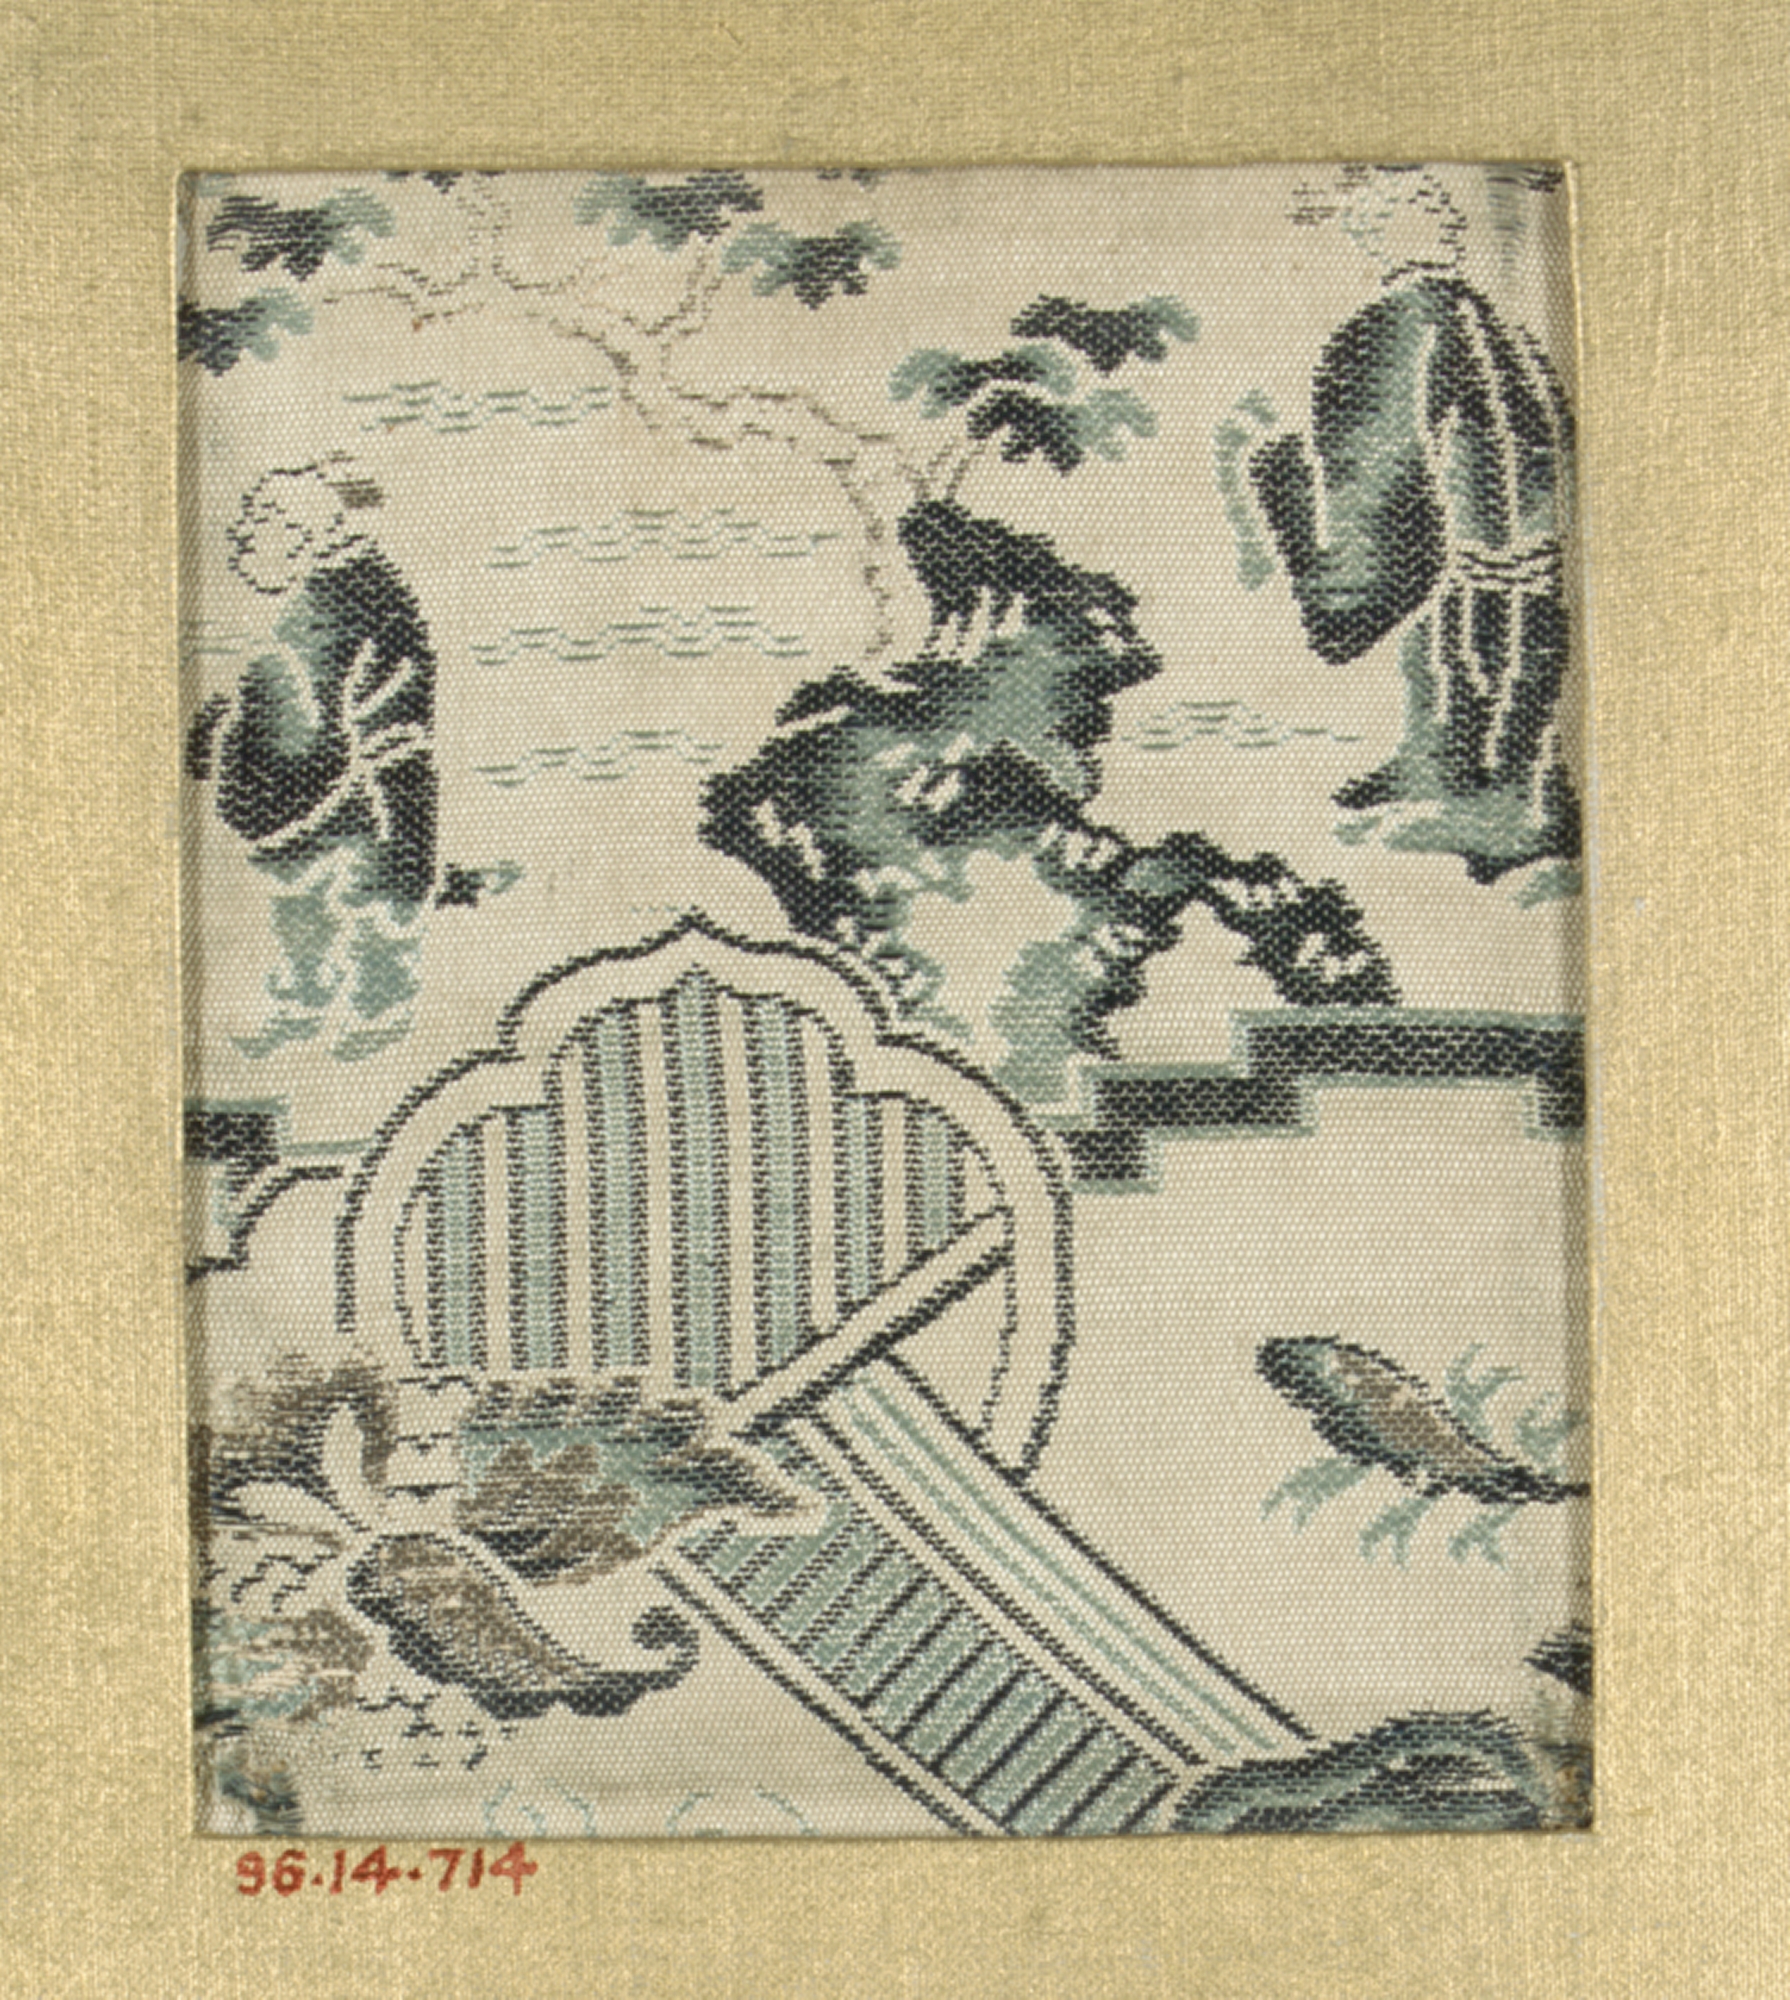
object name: piece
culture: japanese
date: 1701-1900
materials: silk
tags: human figures